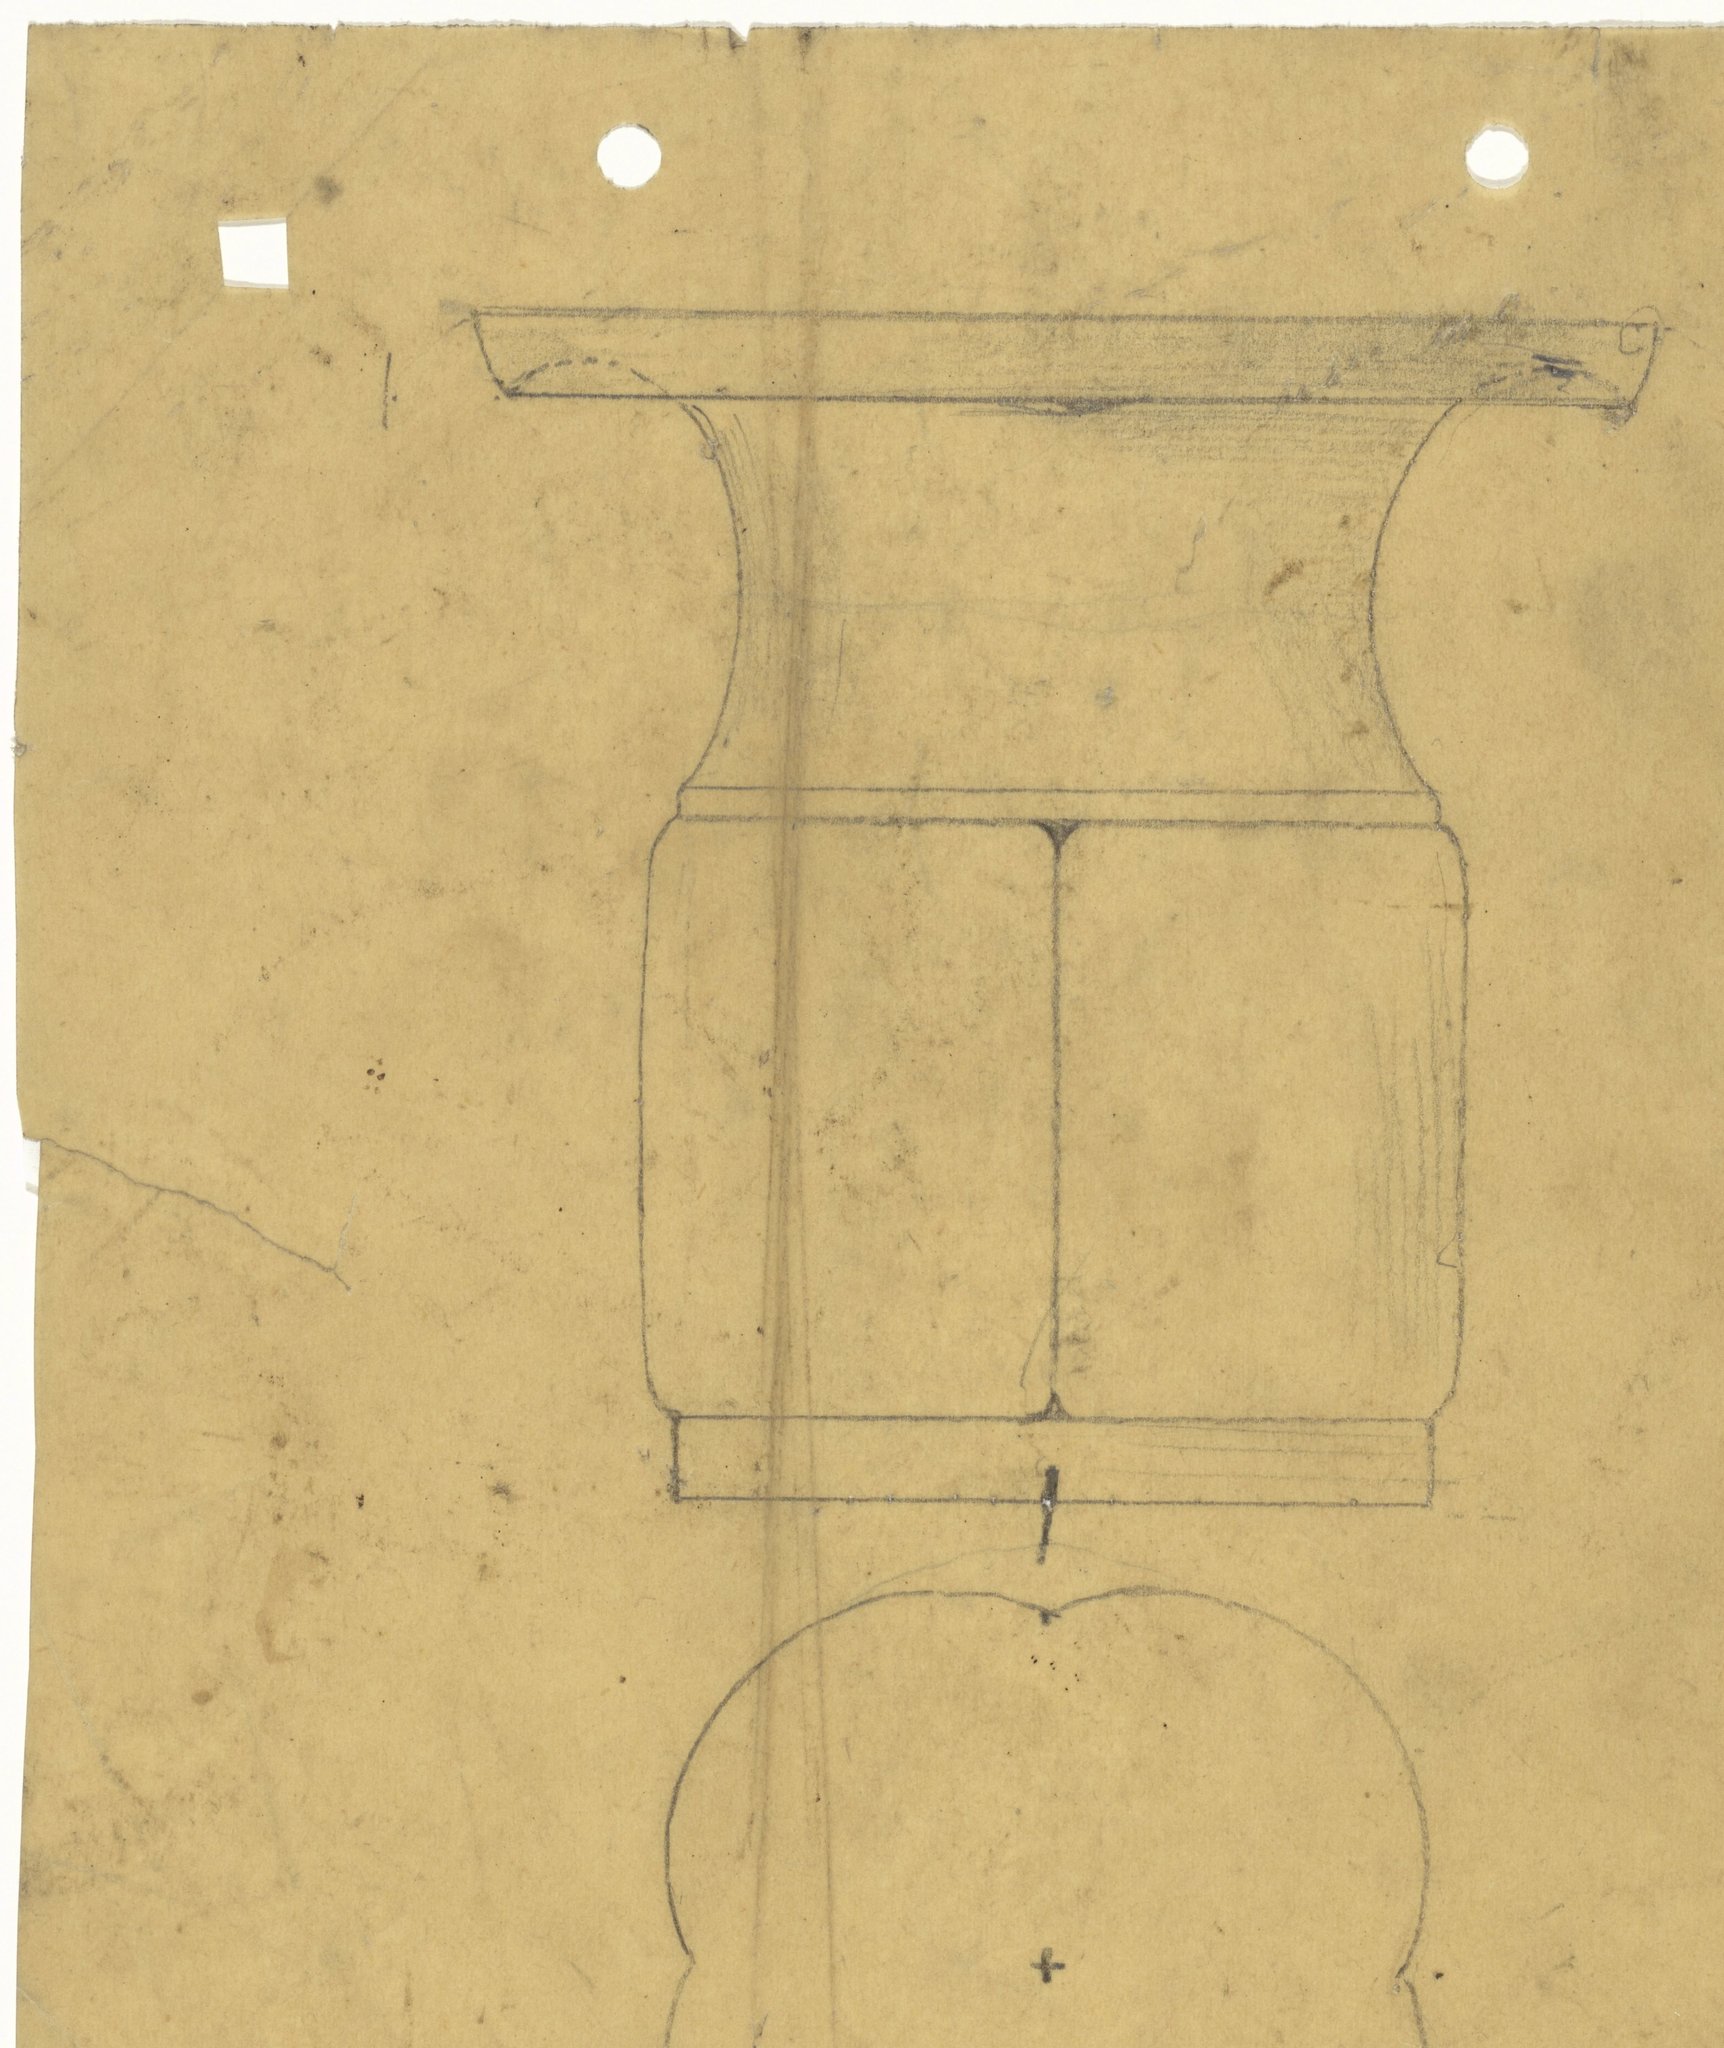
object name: design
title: Ontwerp voor een doopbeker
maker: mathieu lauweriks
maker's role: designer, draughtsman, print maker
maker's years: 1864-1932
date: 1874-1932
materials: pencil, paper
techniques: pricking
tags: other utensils used in the church (baptismal cup)